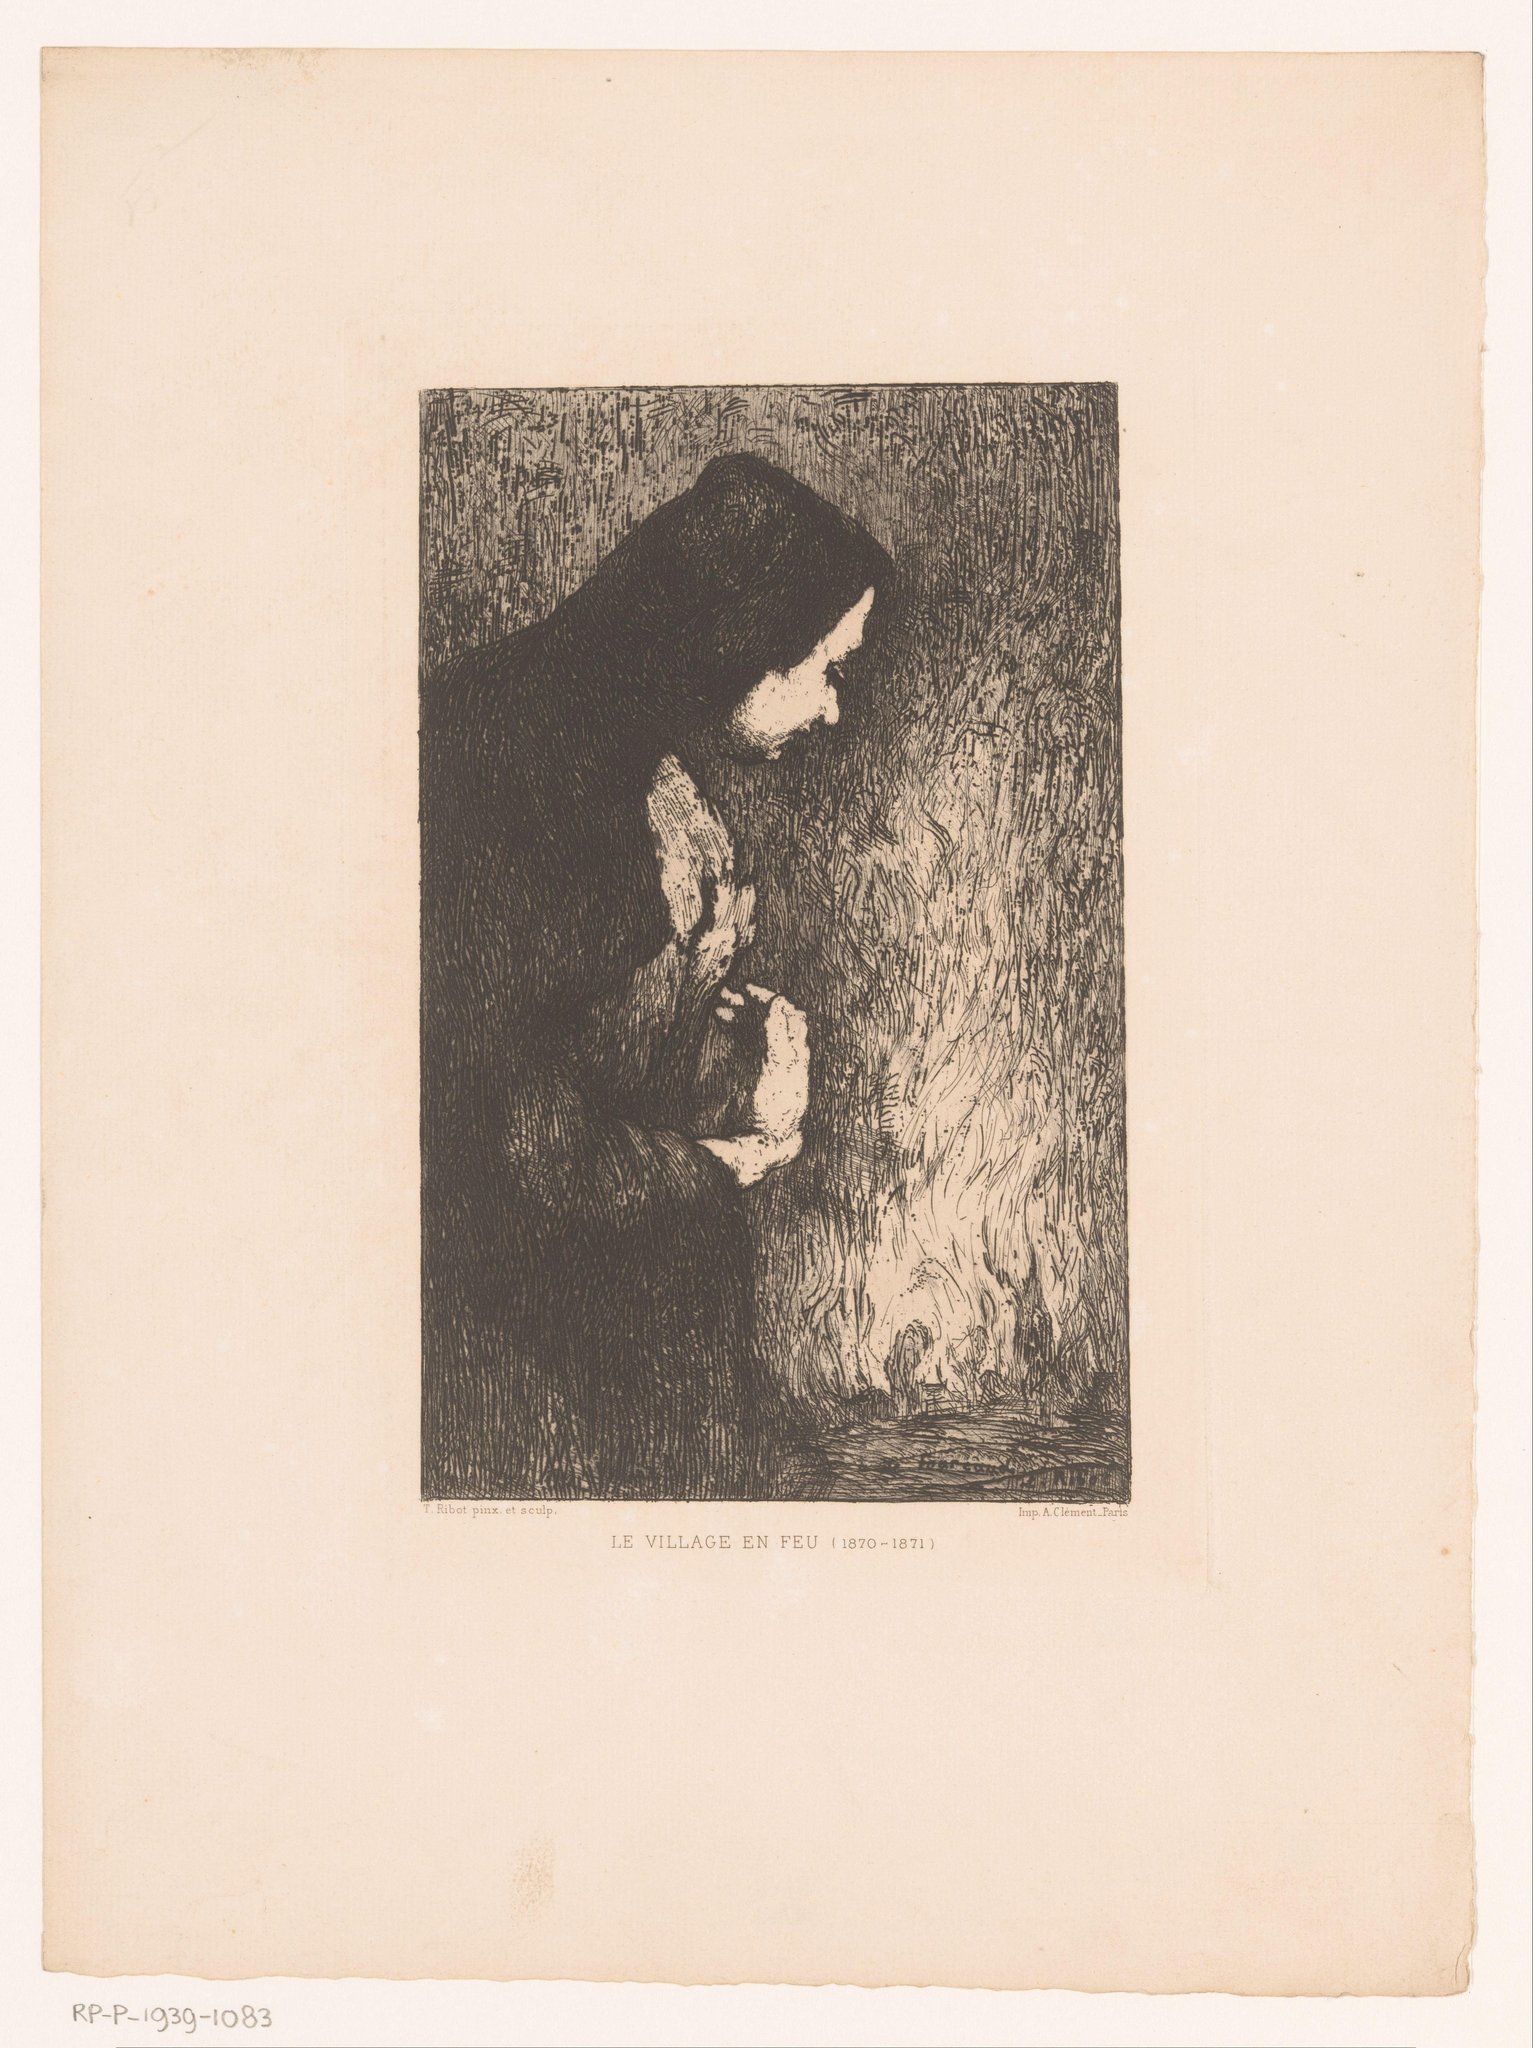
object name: print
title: Staande vrouw kijkend naar brandend dorp op de achtergrond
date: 1870-1871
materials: paper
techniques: drypoint, etching, intaglio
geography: paris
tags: on fire, ablaze, adult woman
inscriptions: collector's mark: Lugt 2166, collector's mark: Lugt 2760